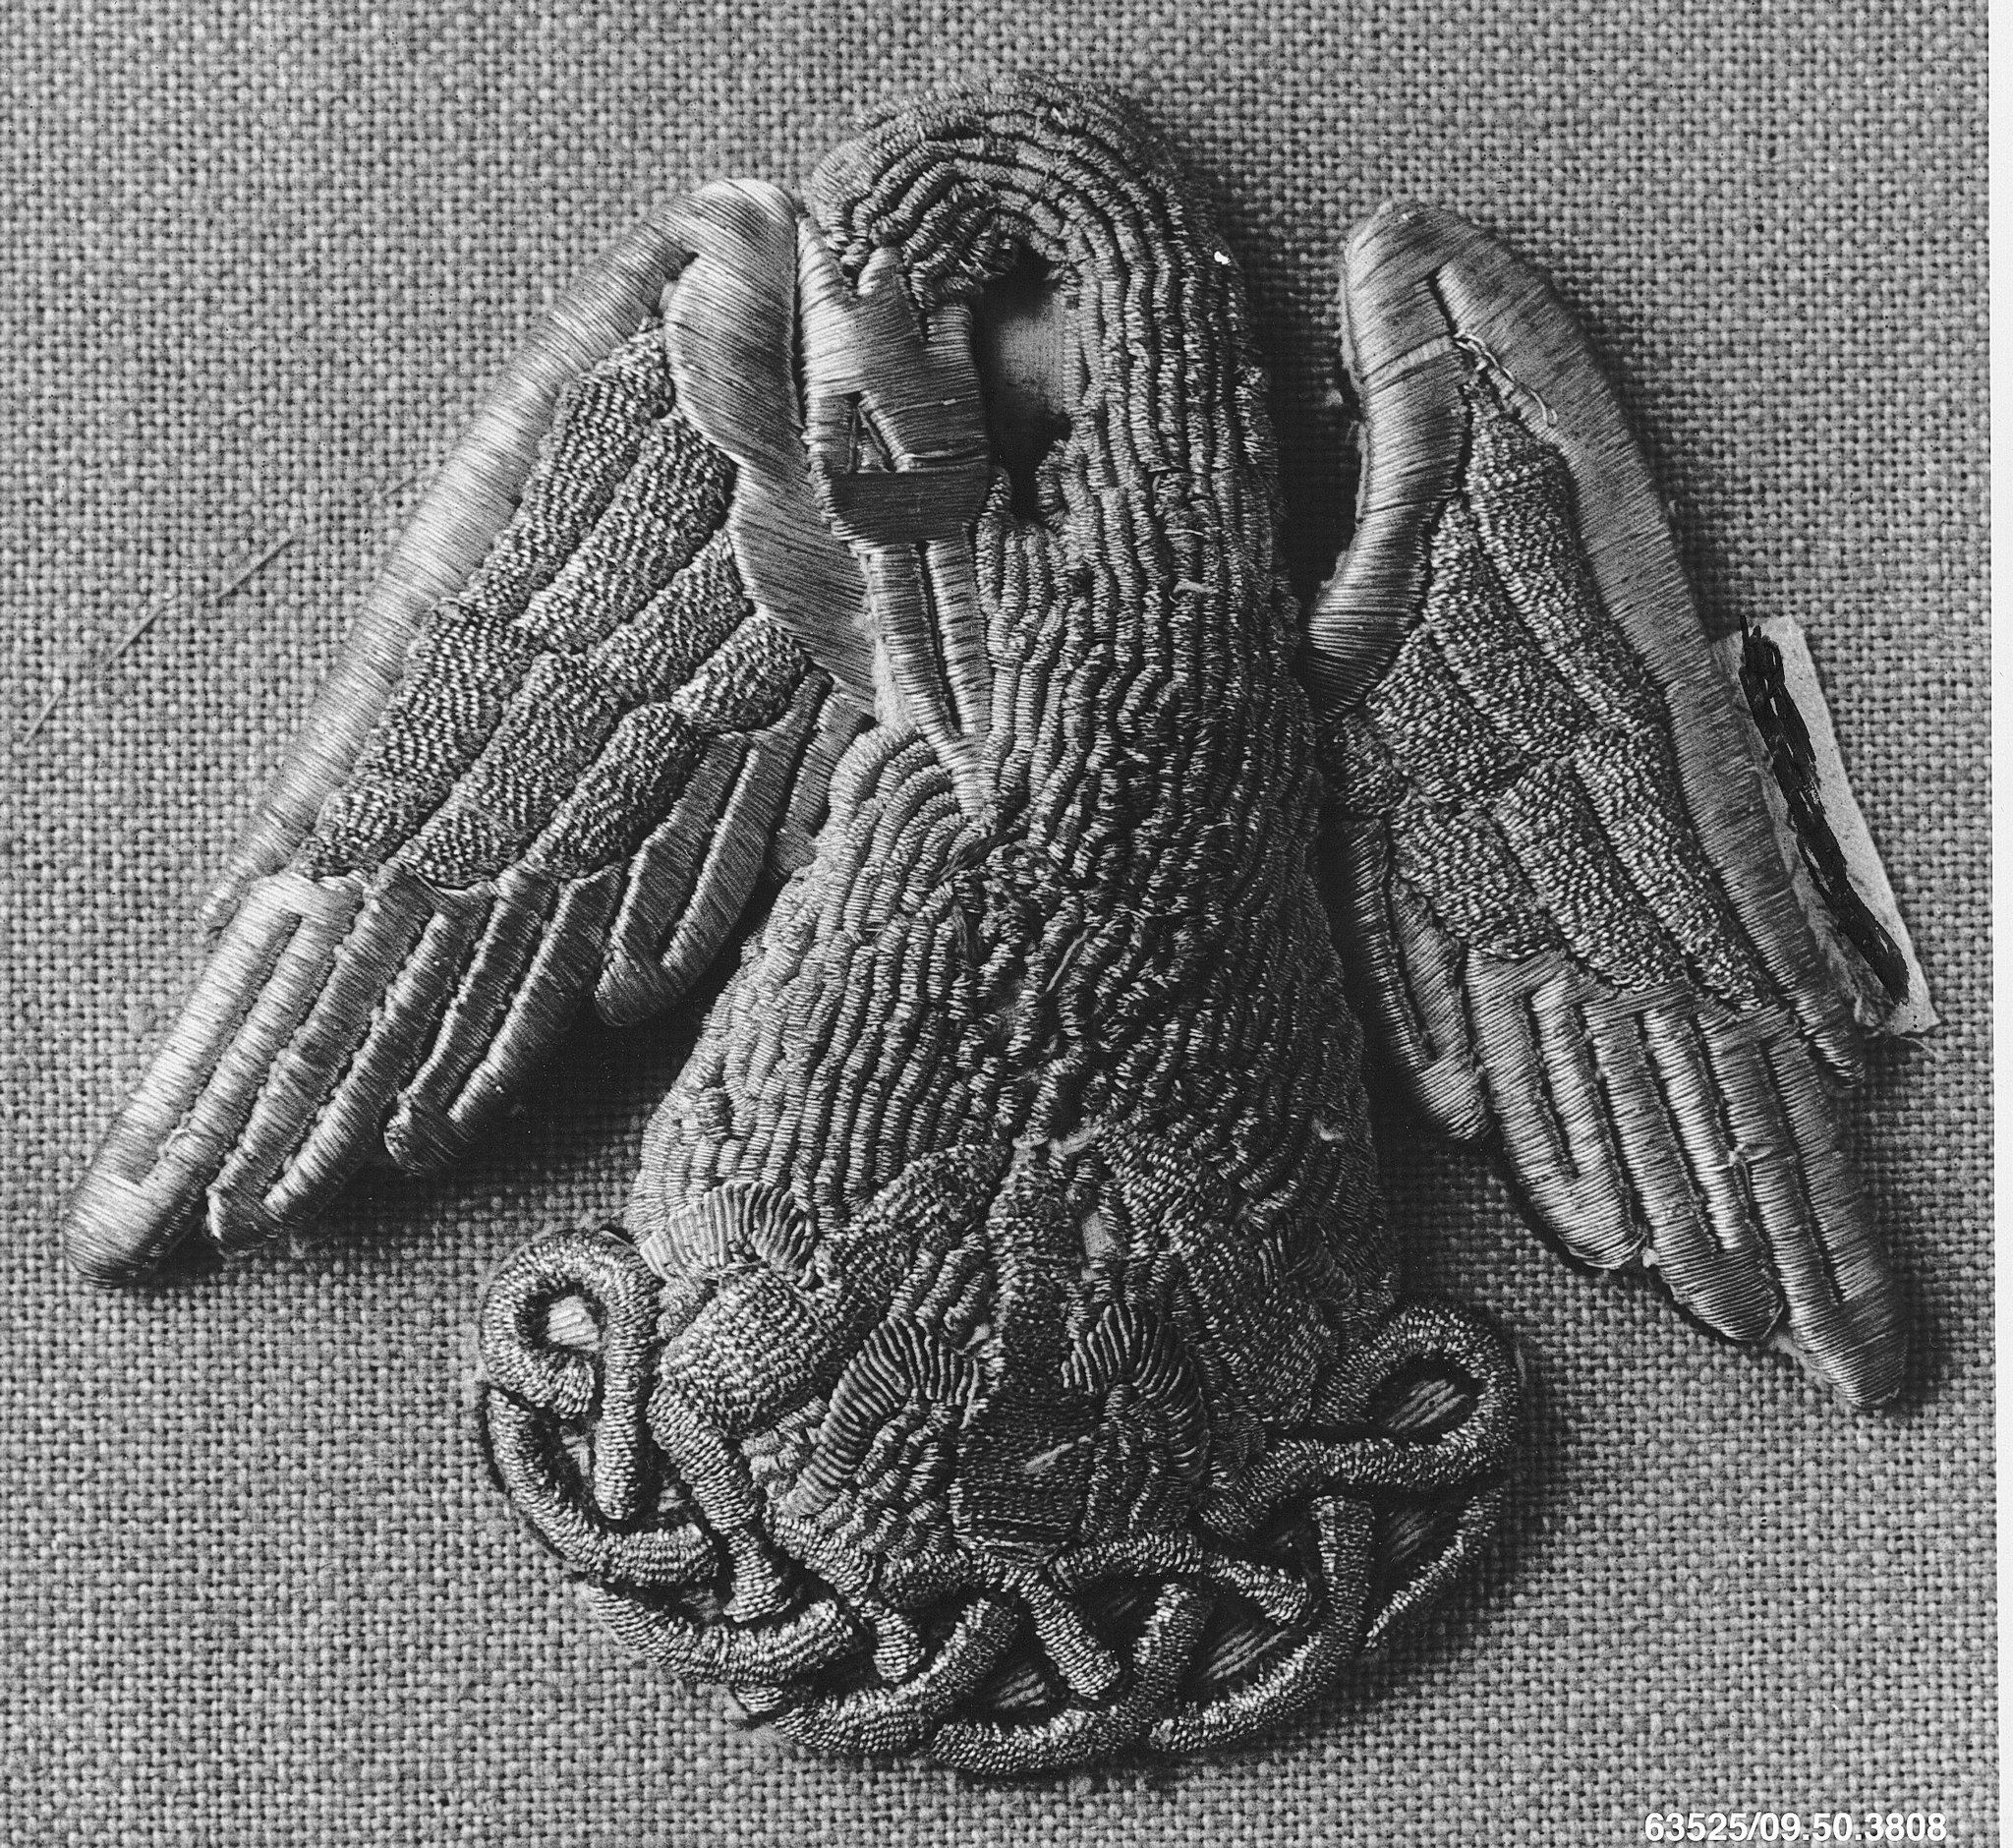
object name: ornament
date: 1801-1900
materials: metal thread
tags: birds